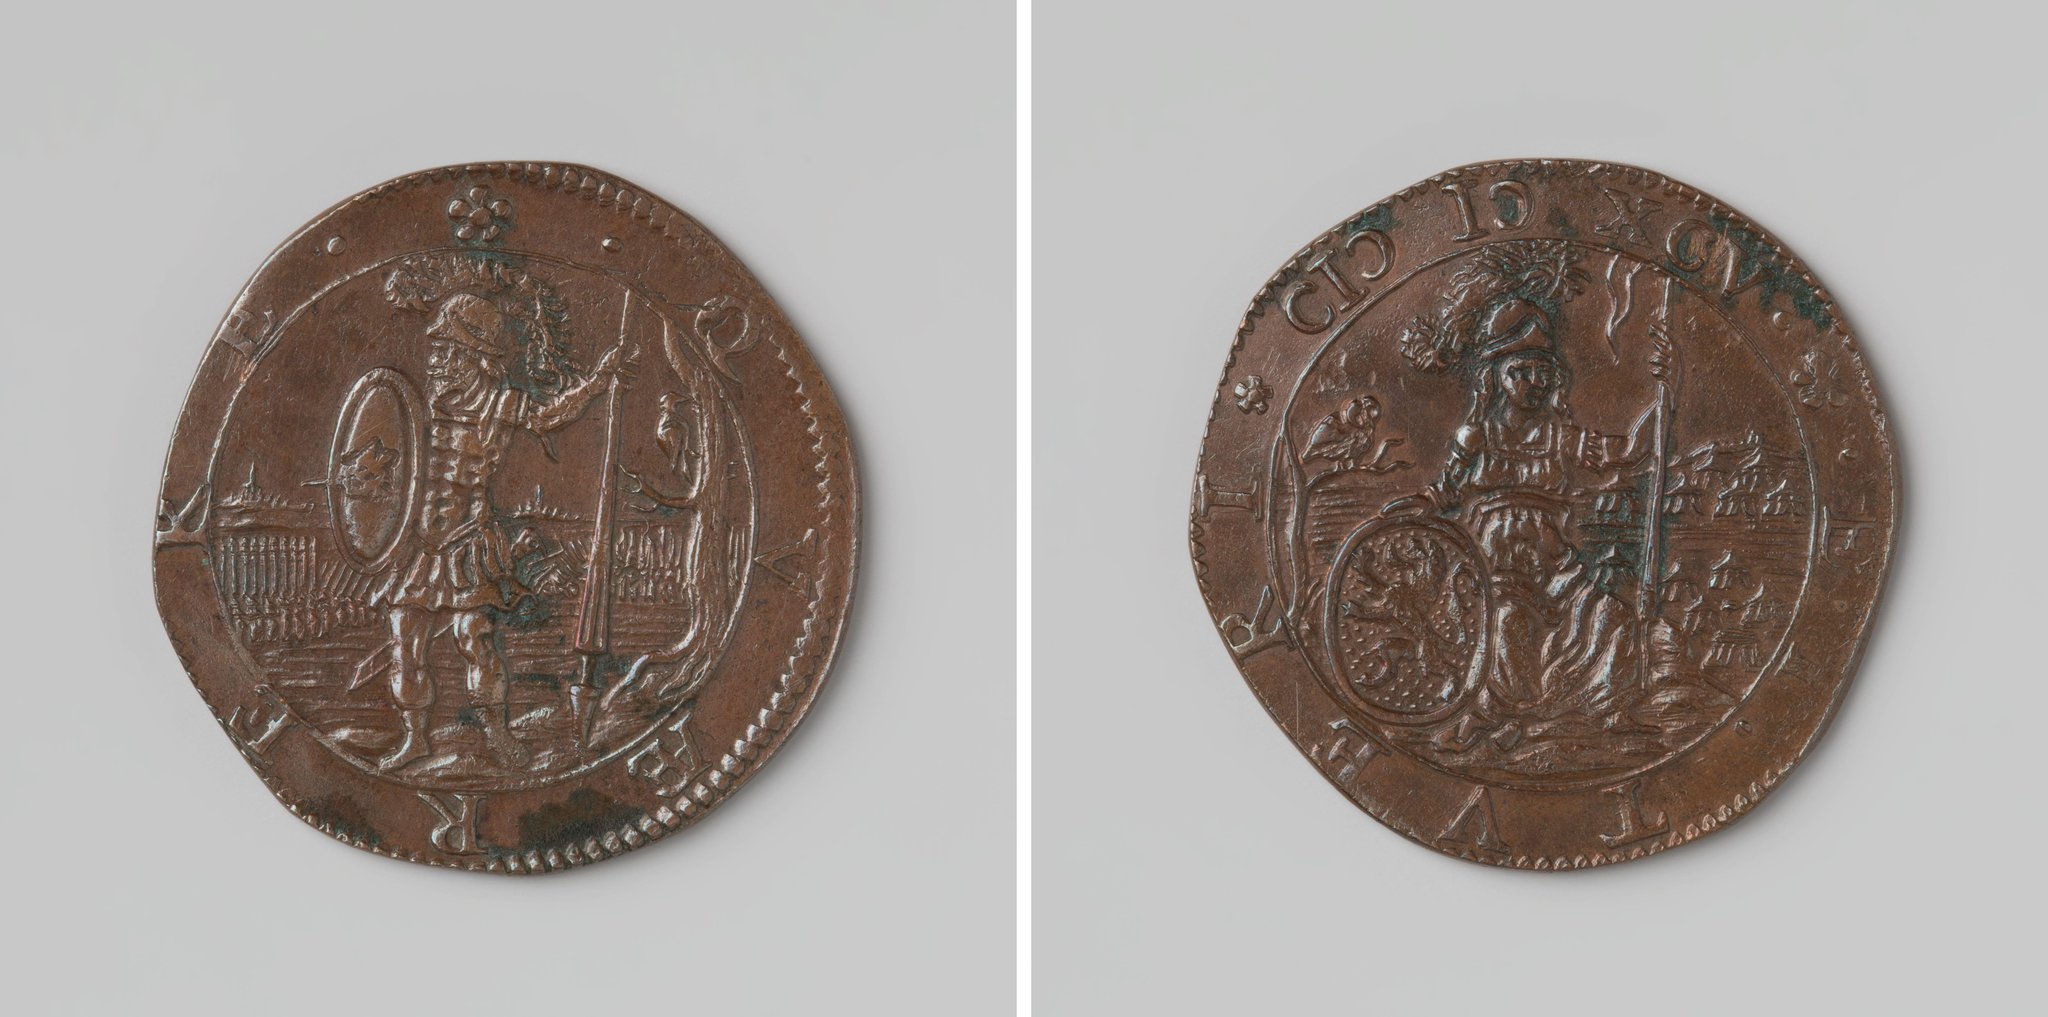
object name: jeton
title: Patstelling tussen de Nederlandse en Spaanse legers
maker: Anonymous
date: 1595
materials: copper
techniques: striking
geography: dordrecht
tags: the hague, maurice (prince of orange)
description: Koperen penning. Voorzijde: Maurits, afgebeeld als gehelmde Mars met schild en speer; op achtergrond troepen. Keerzijde: gehelmde Minerva met schild en speer zittend voor tentenkamp binnen omschrift